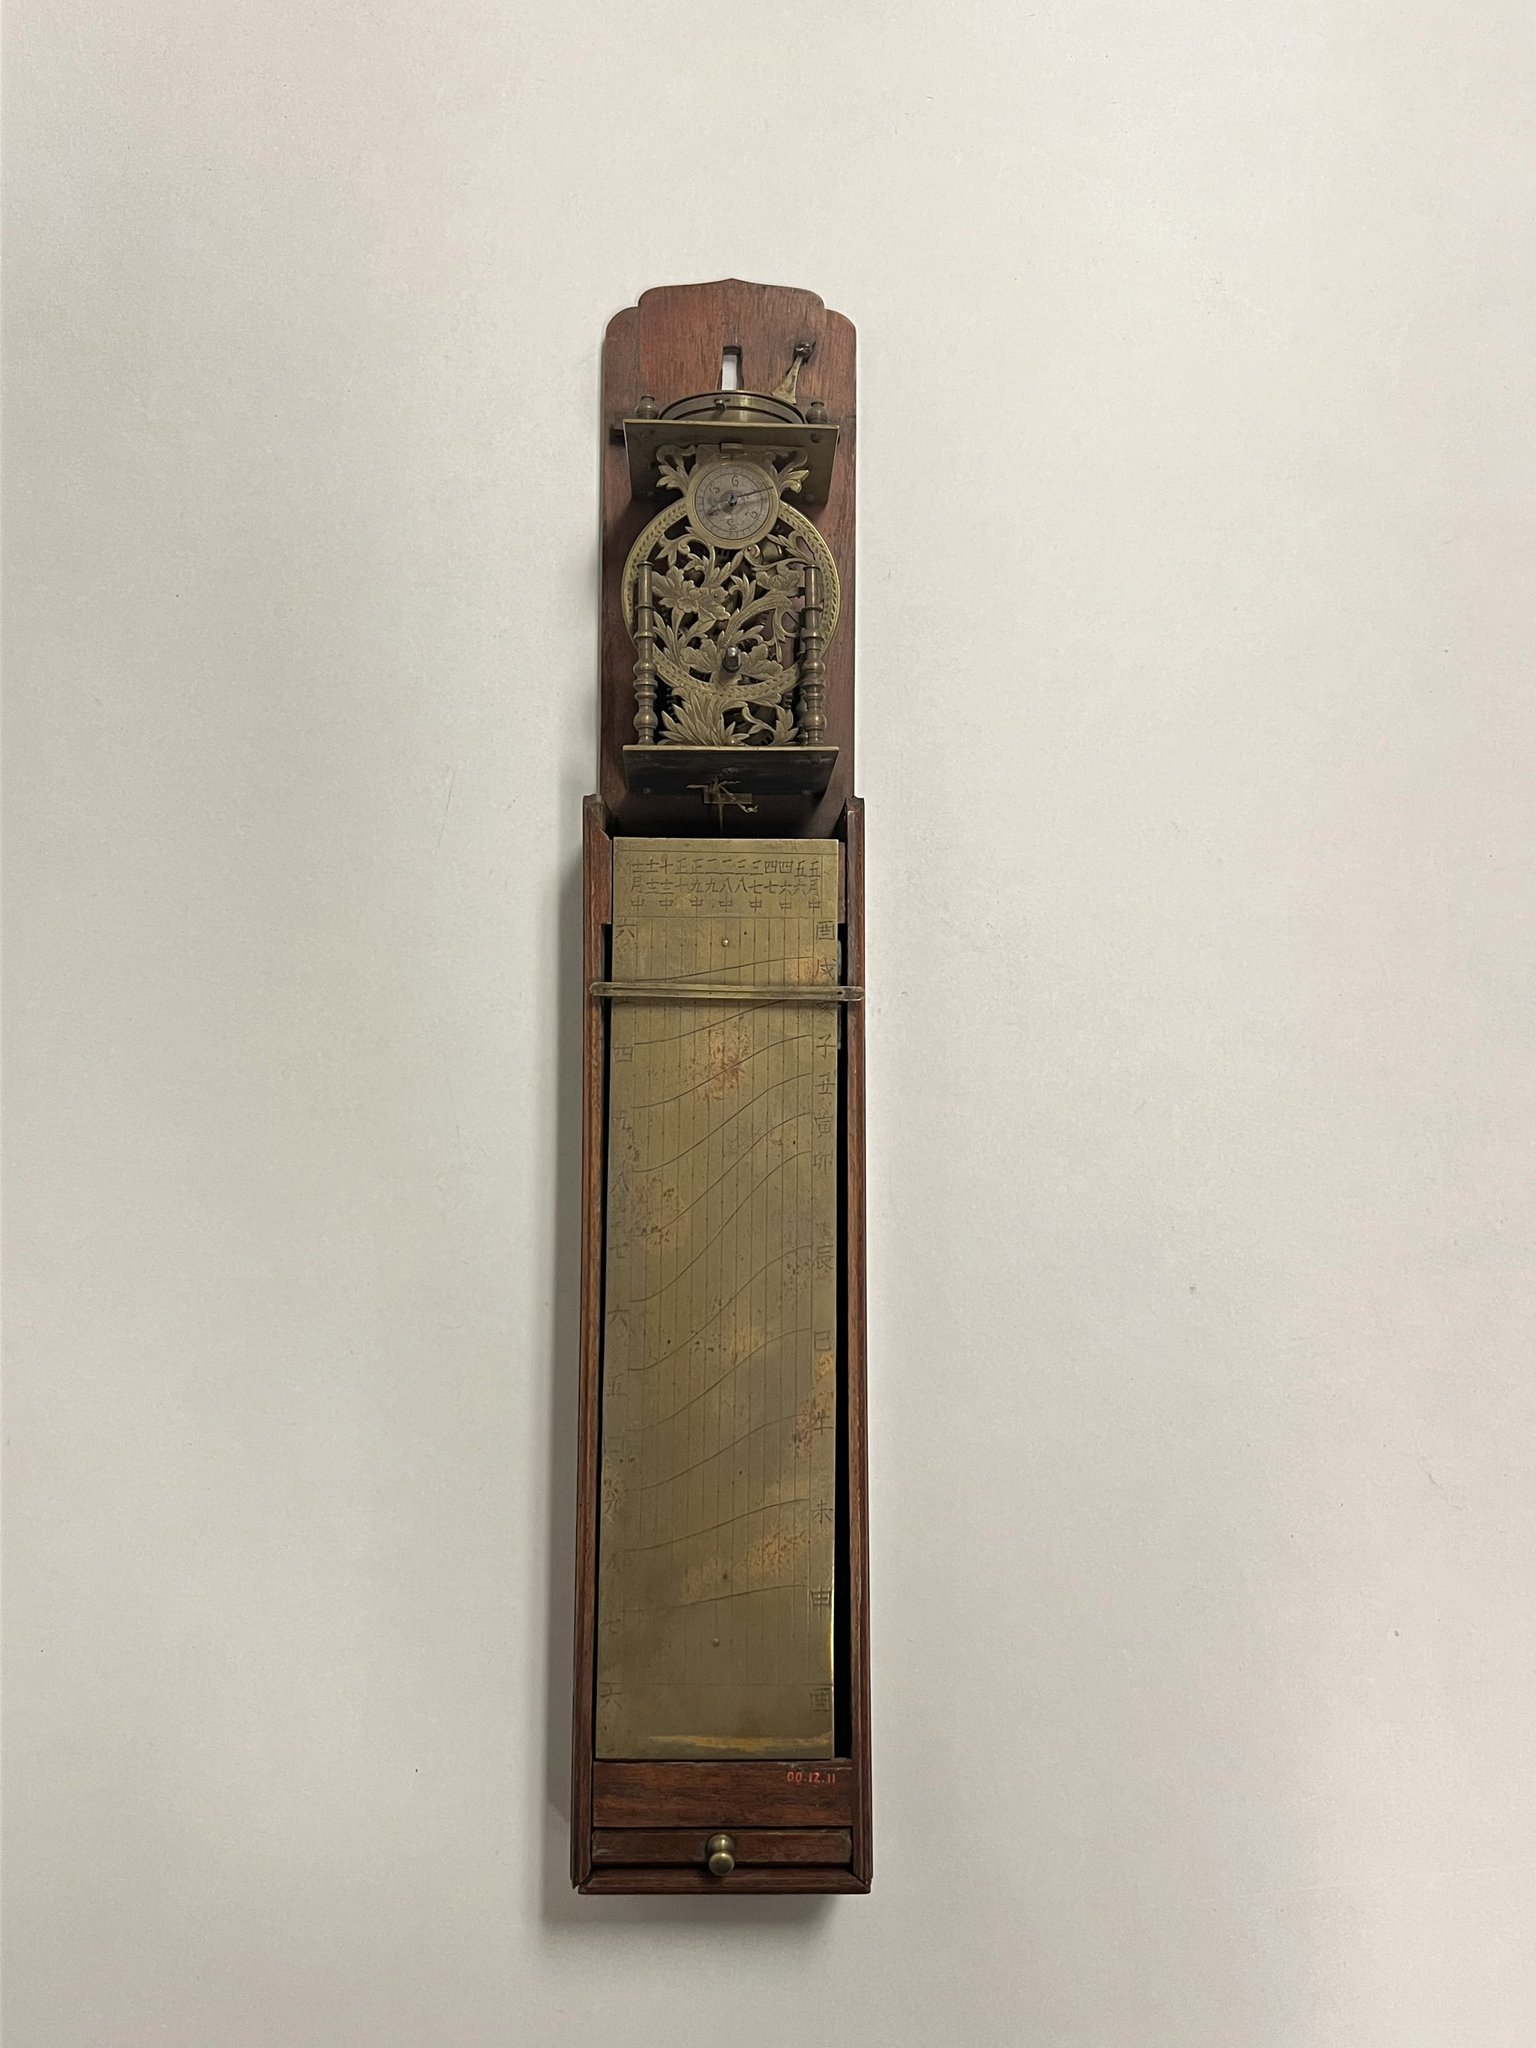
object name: clock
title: Wall Clock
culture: japanese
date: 1801-1900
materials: brass, wood